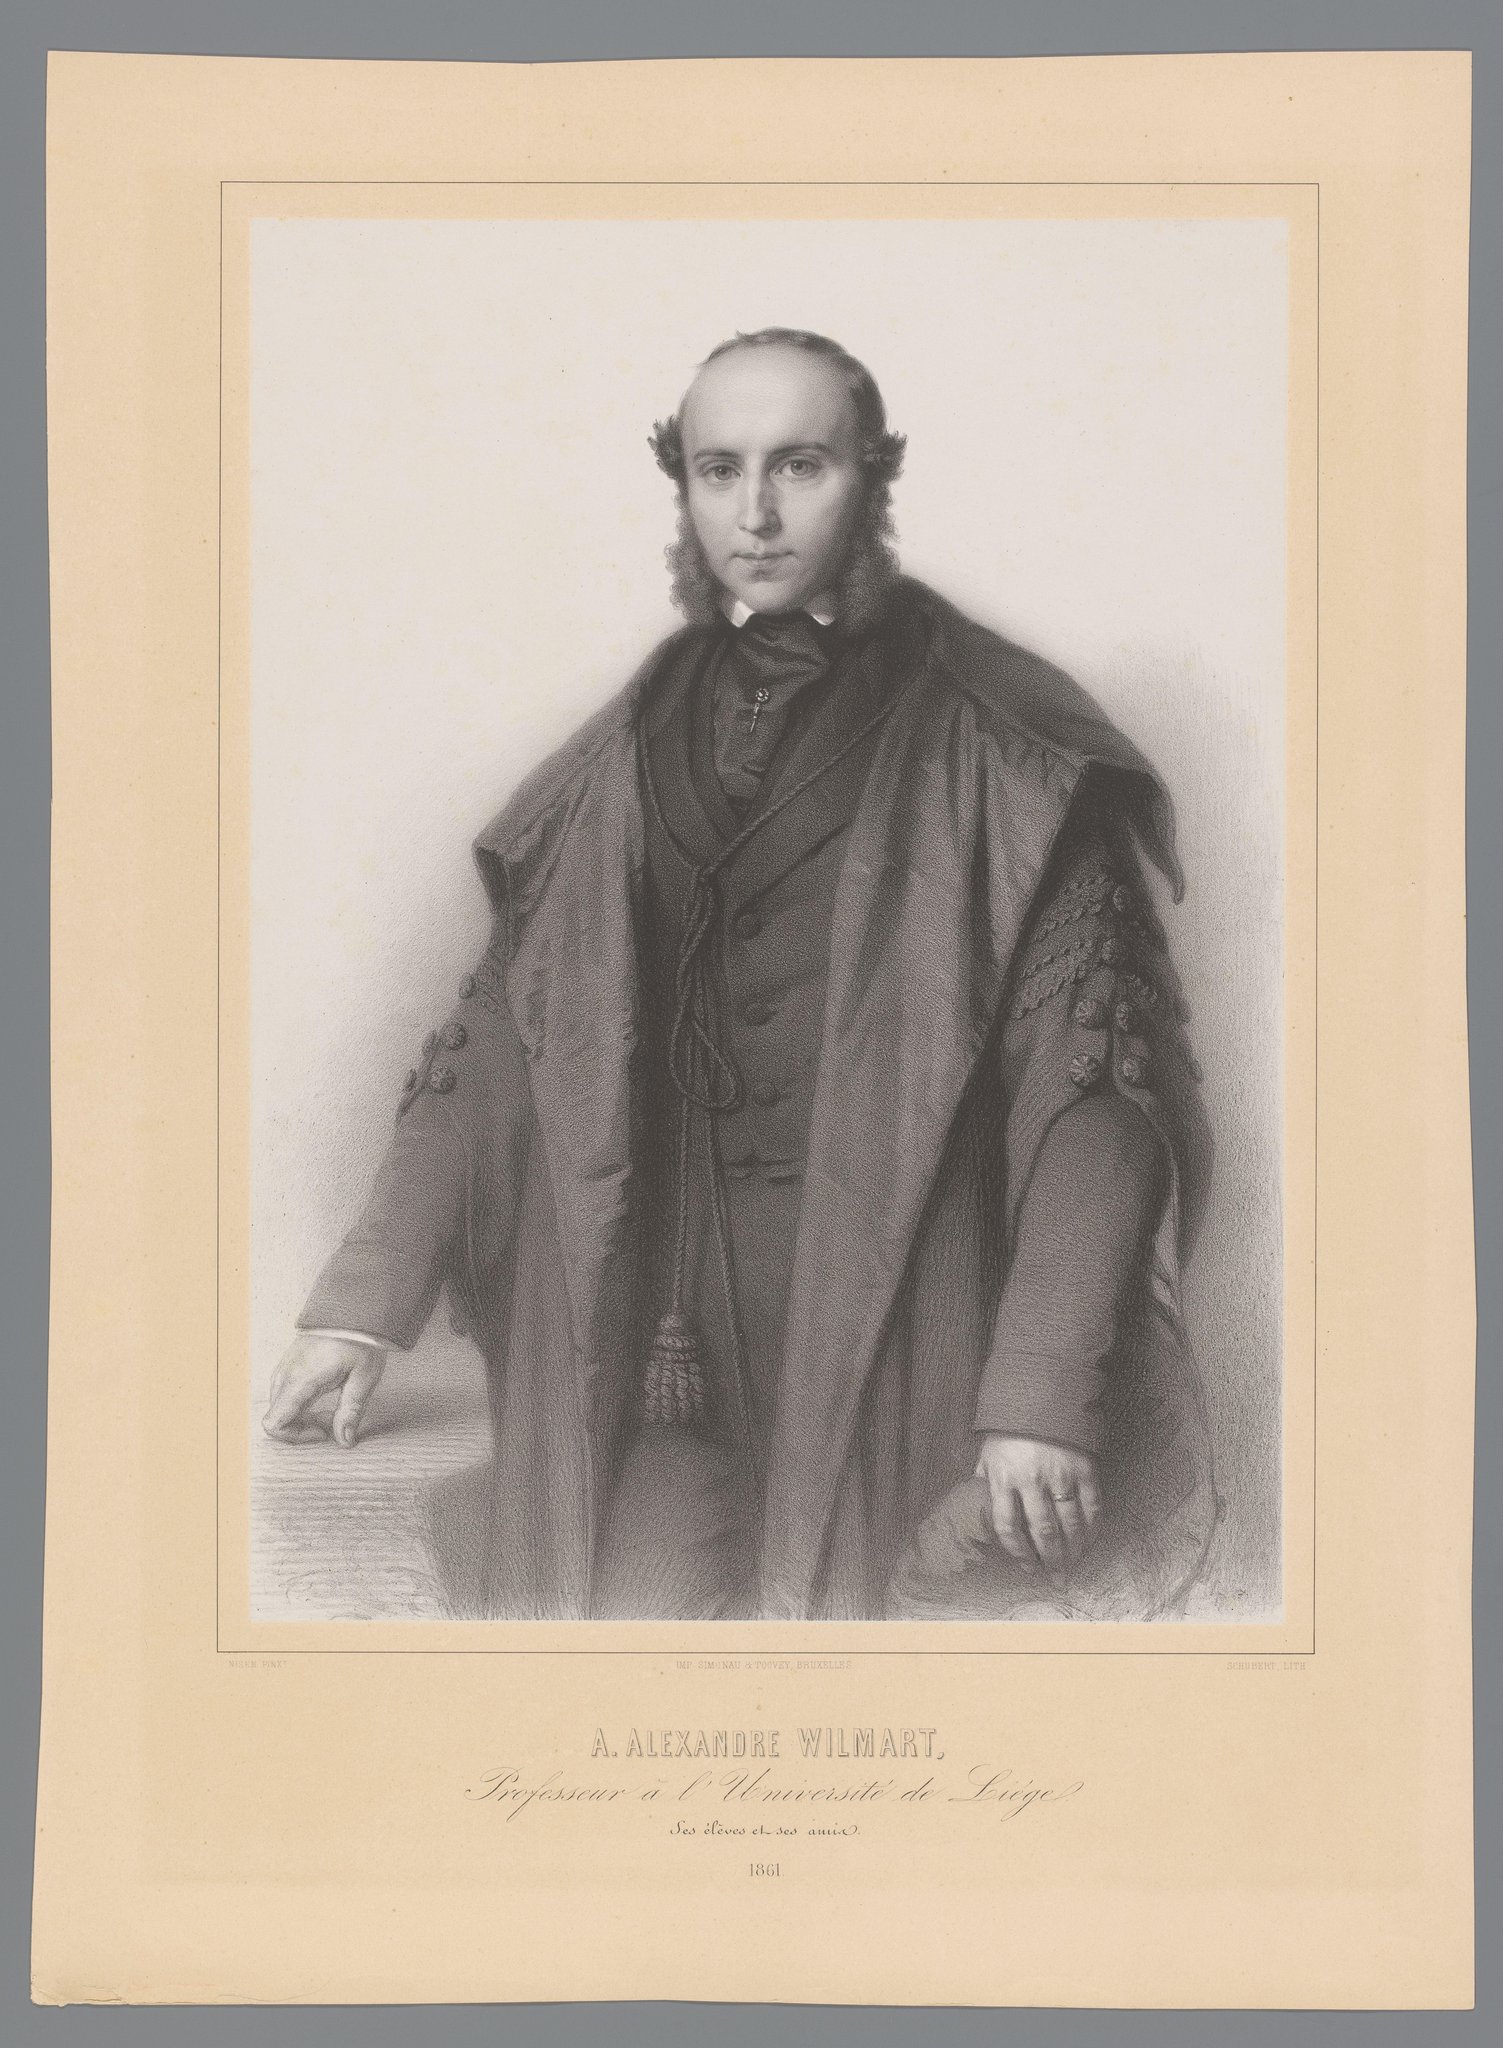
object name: print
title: Portret van Pierre-Alexandre Wilmart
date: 1861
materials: paper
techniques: lithograph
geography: brussels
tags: liège, pierre-alexandre wilmart, historical persons, medicine, medical science (+ portrait of scholar, scientist)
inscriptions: collector's mark: Lugt 2228